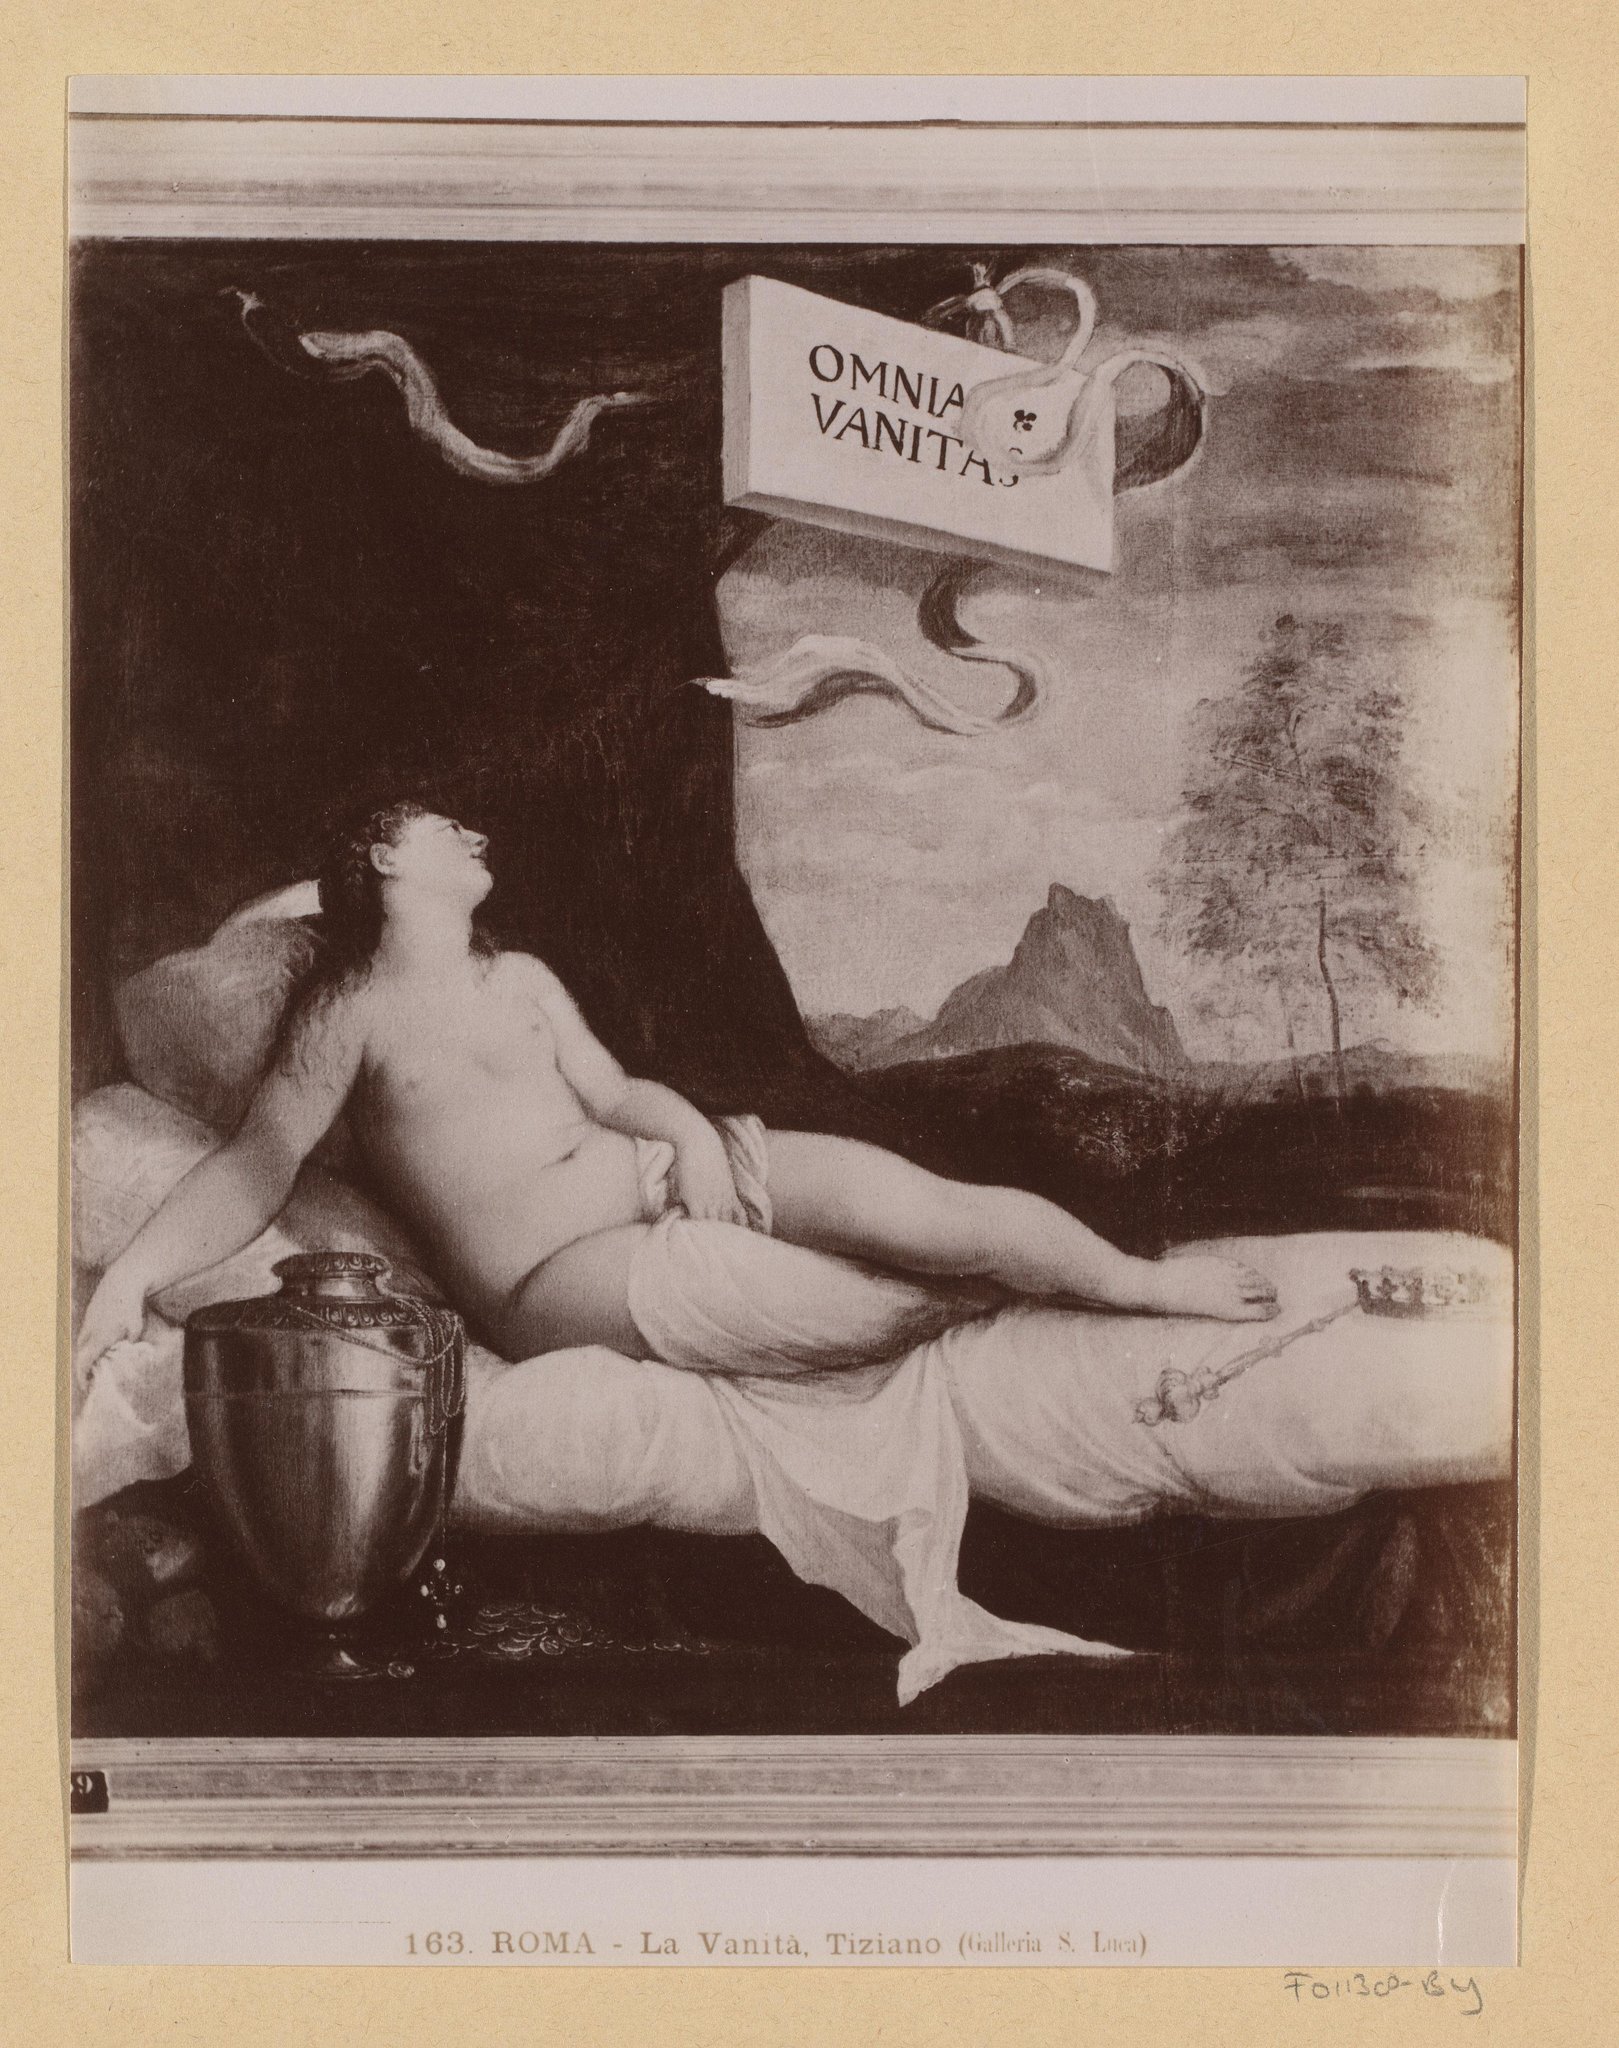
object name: reproduction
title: Fotoreproductie van een schilderij, voorstellend een liggende vrouw als personificatie van de IJdelheid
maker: Anonymous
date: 1860-1900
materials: photographic support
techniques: albumen print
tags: scenes symbolizing 'vanitas'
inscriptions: number: ‘163’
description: Onderdeel van Reisalbum met opnames van kunstwerken en bezienswaardigheden in Italië, Griekenland en Frankrijk.